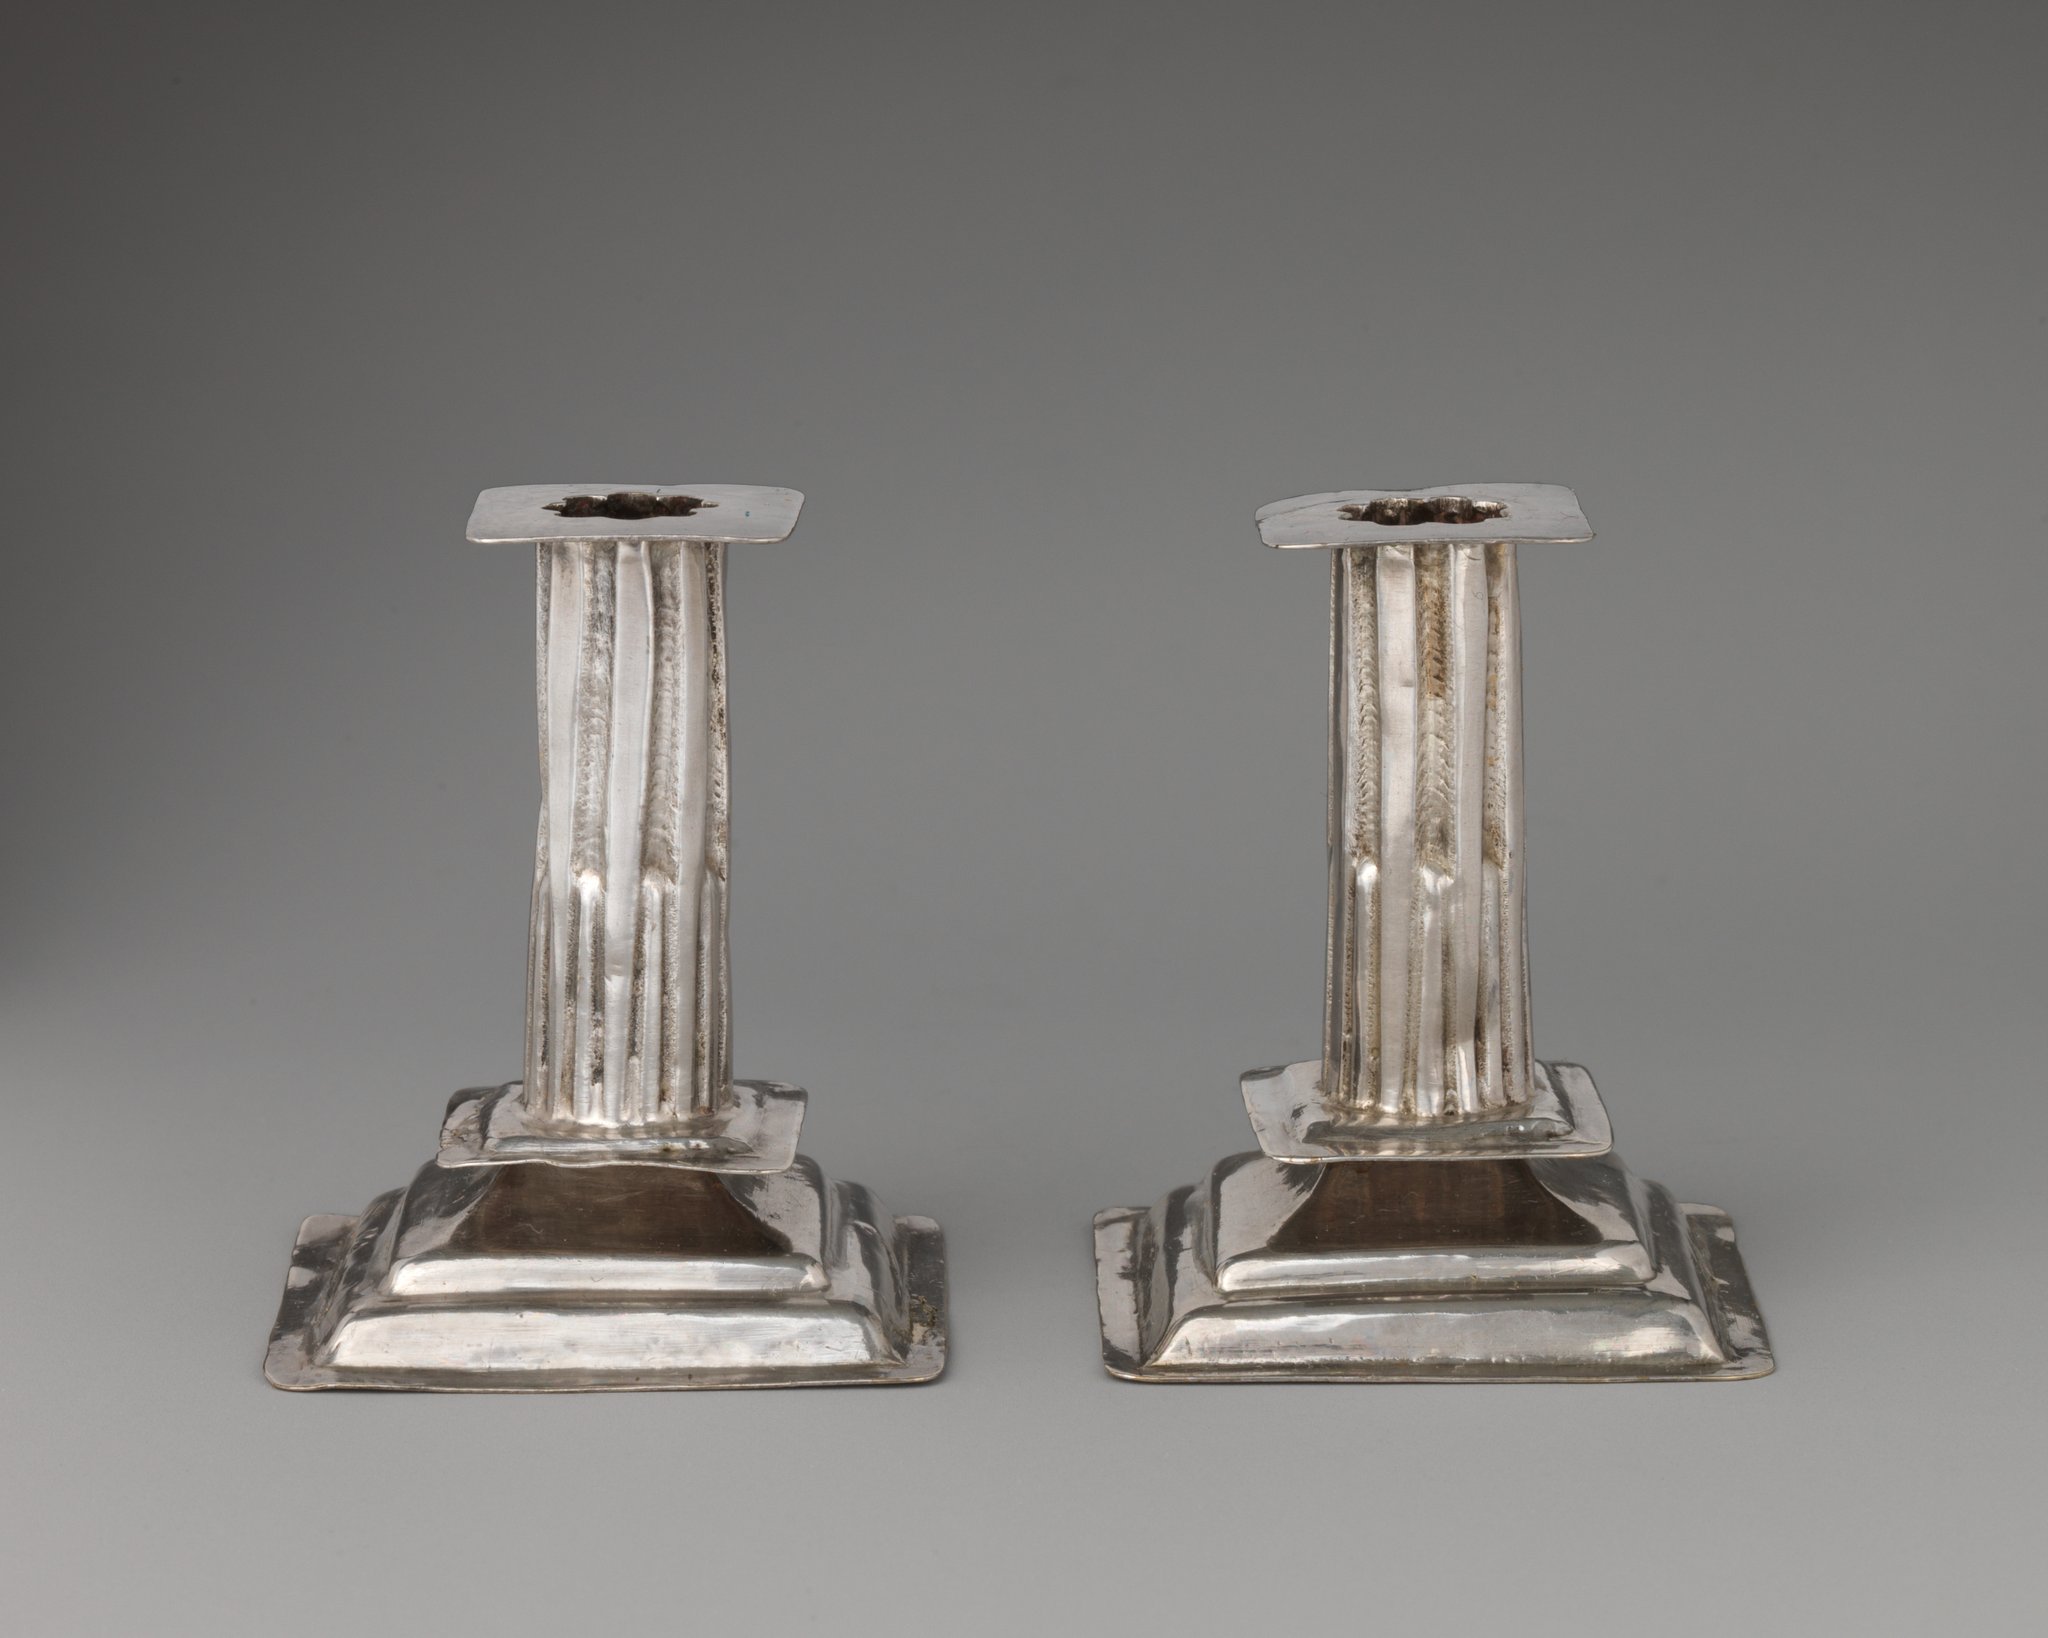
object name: candlestick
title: Pair of miniature candlesticks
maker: george manjoy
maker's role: maker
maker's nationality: british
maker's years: 1685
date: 1685-1686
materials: silver